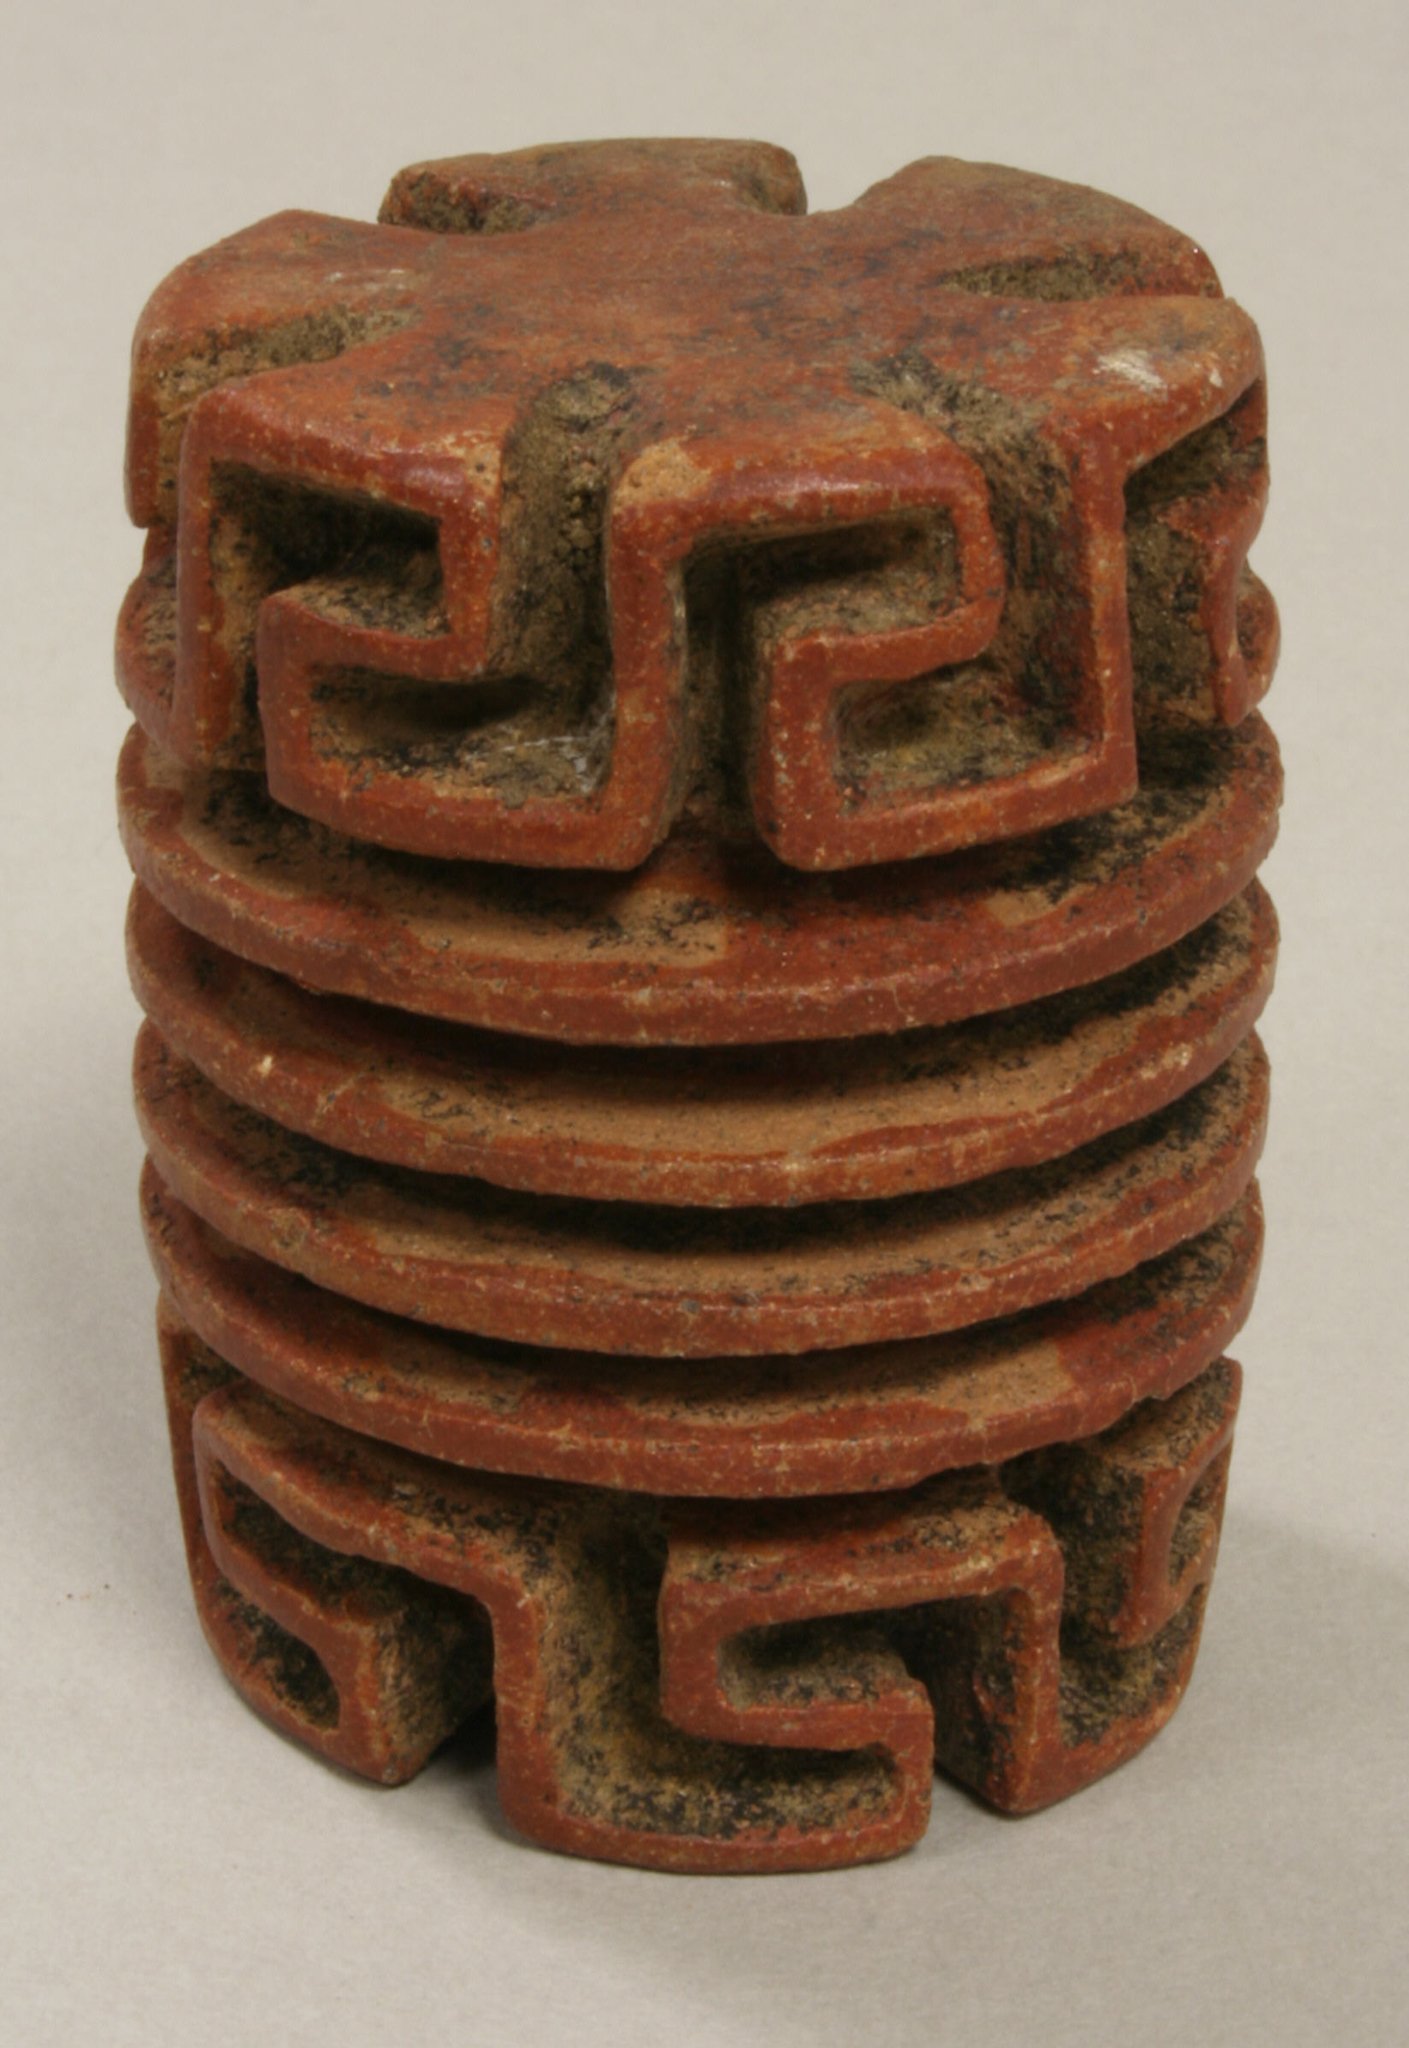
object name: stamp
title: Rolelr Stamp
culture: atlantic watershed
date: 401-600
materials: ceramic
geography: costa rica